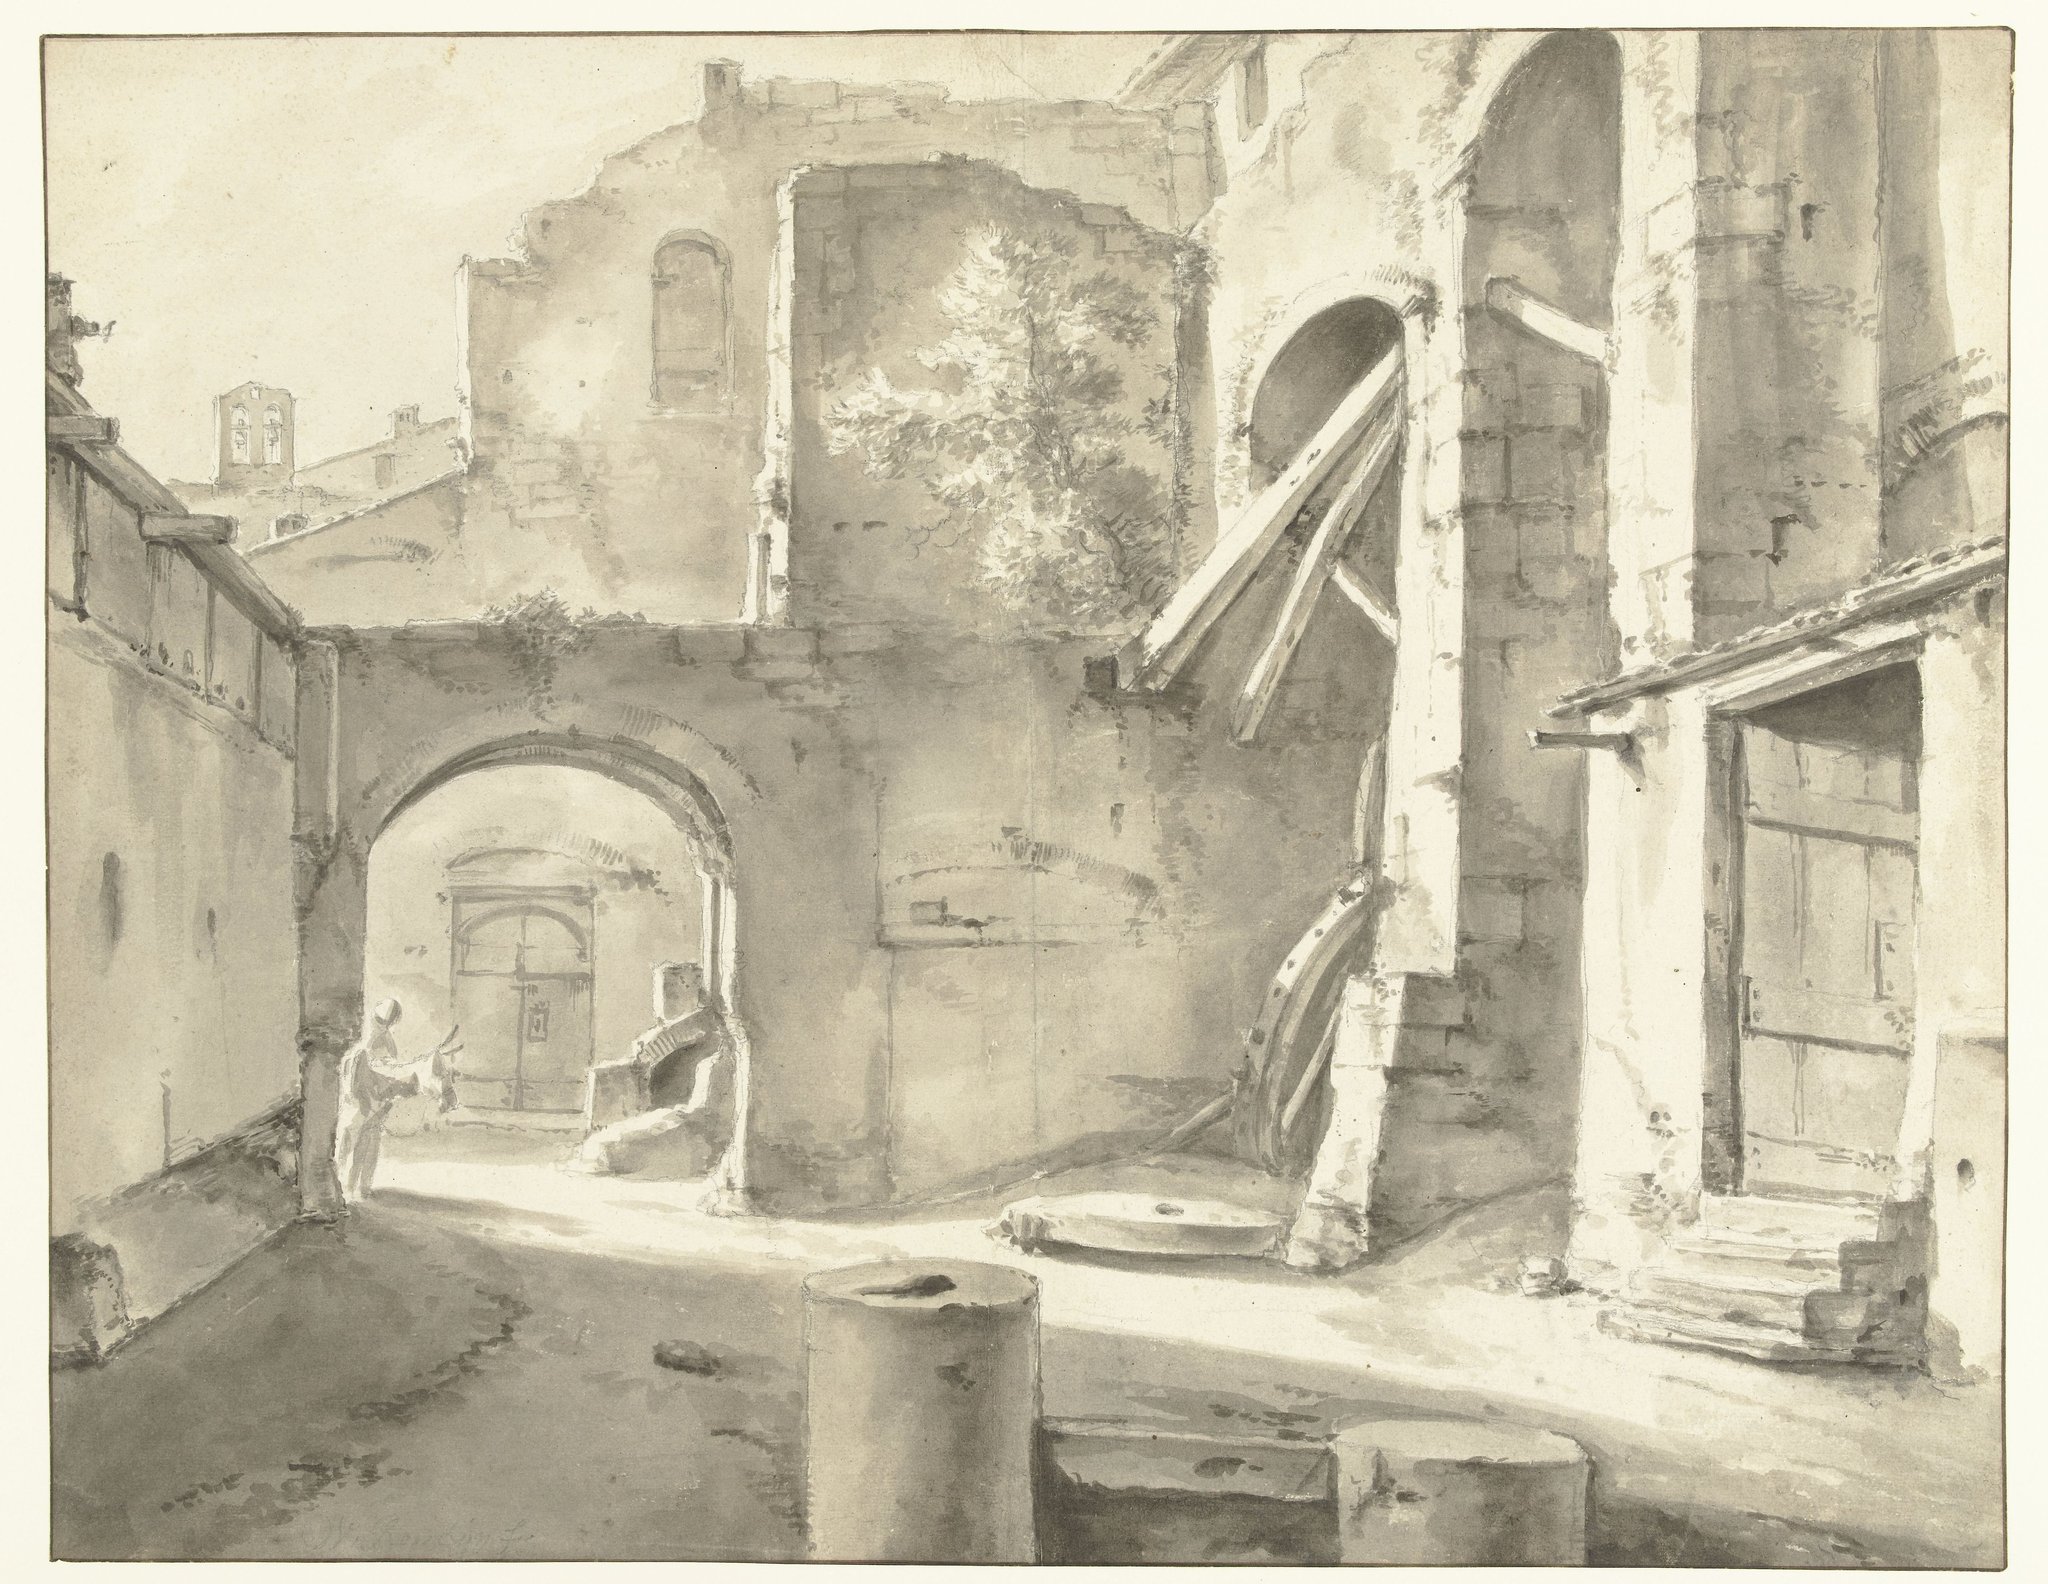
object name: drawing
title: Italiaanse gebouwen met links een poort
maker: thomas wijck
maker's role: draughtsman, painter, print maker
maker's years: 1616-1677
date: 1626-1677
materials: chalk, paper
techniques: brush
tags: village street, italy